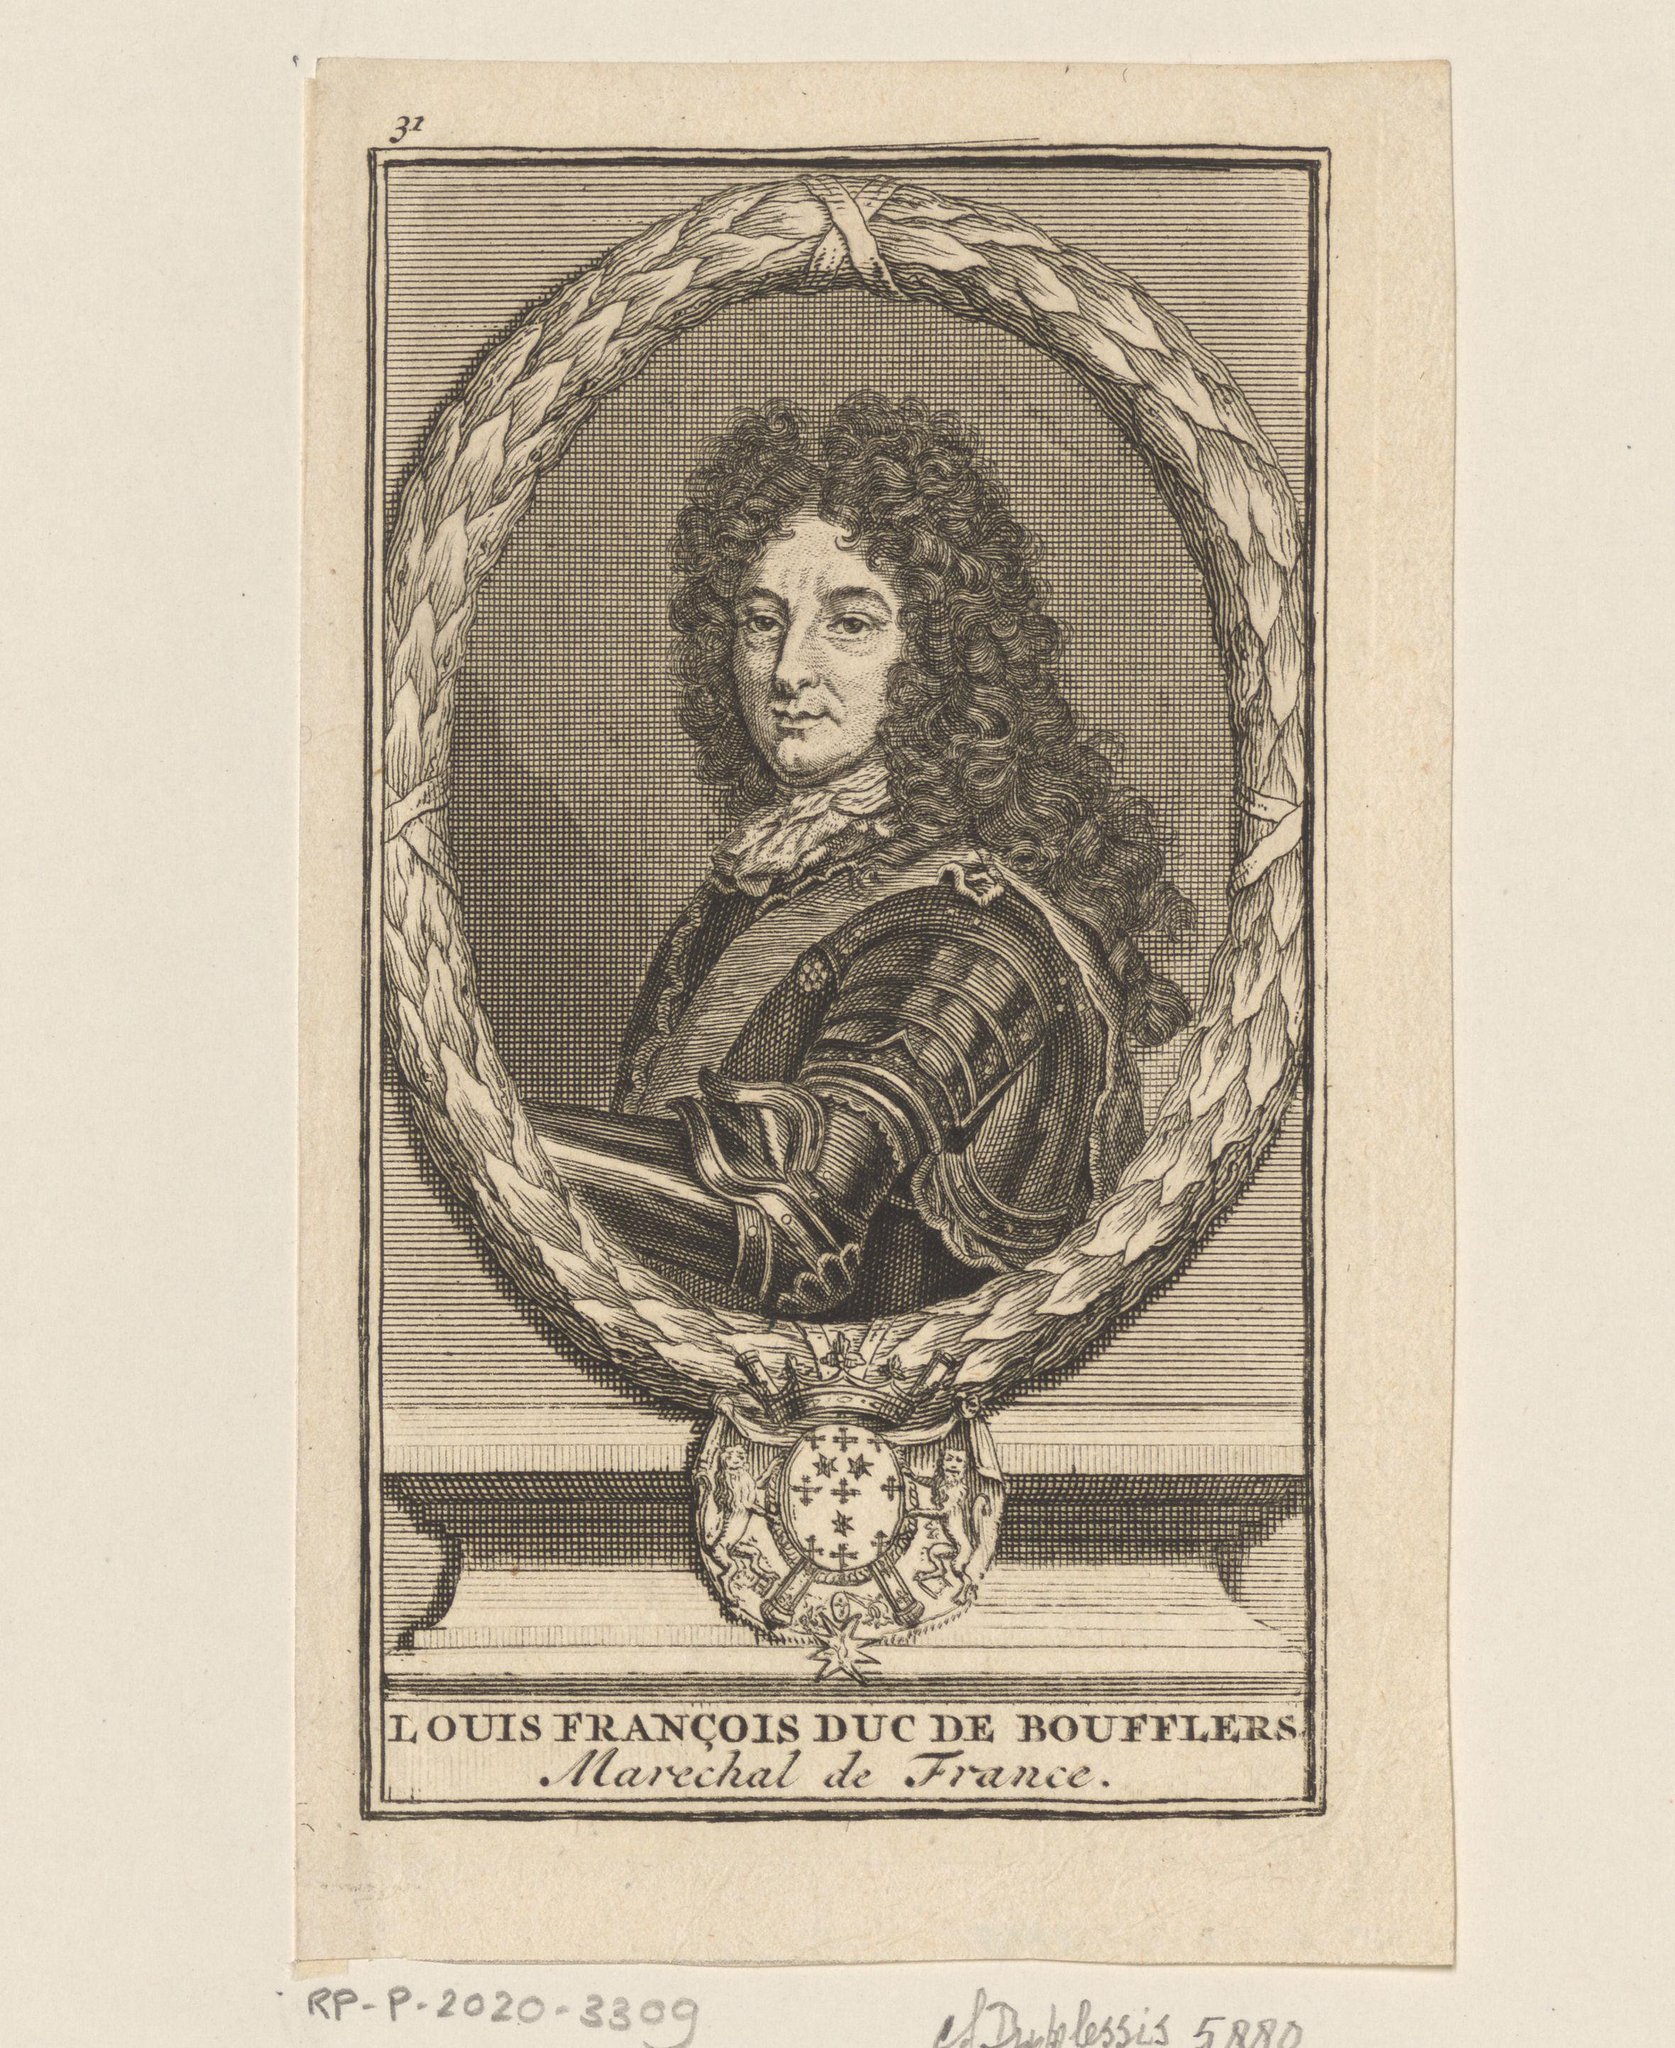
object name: print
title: Portret van Louis-François, hertog van Boufflers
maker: Anonymous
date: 1700-1749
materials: paper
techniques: engraving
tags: commander-in-chief, general, marshal, armour, historical persons, armorial bearing, heraldry